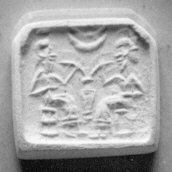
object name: stamp seal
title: Rectangular plaque seal with tubular loop handle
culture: akkadian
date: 2350-2150 BCE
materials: stone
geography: mesopotamia